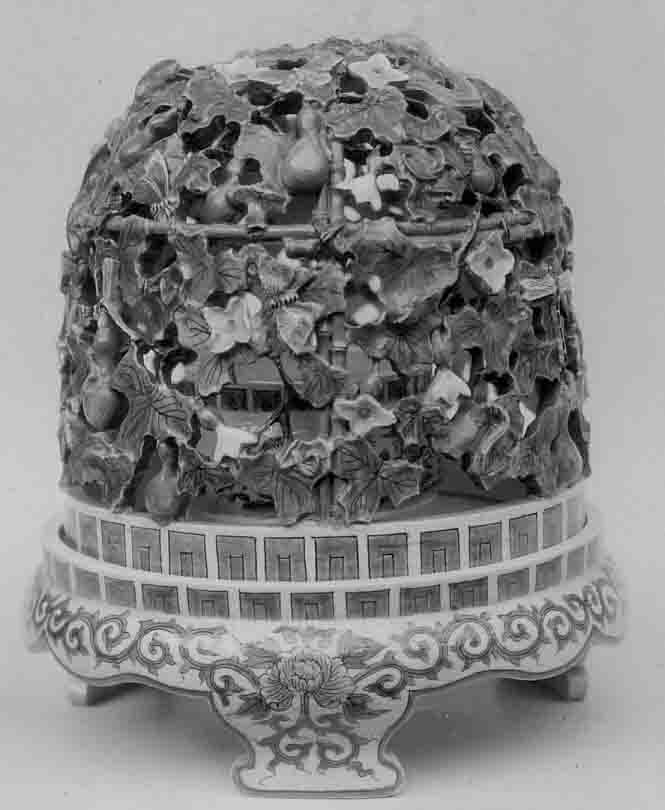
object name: censer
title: Censer in Three Parts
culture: japanese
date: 1850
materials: enamel, faience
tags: flowers,censers